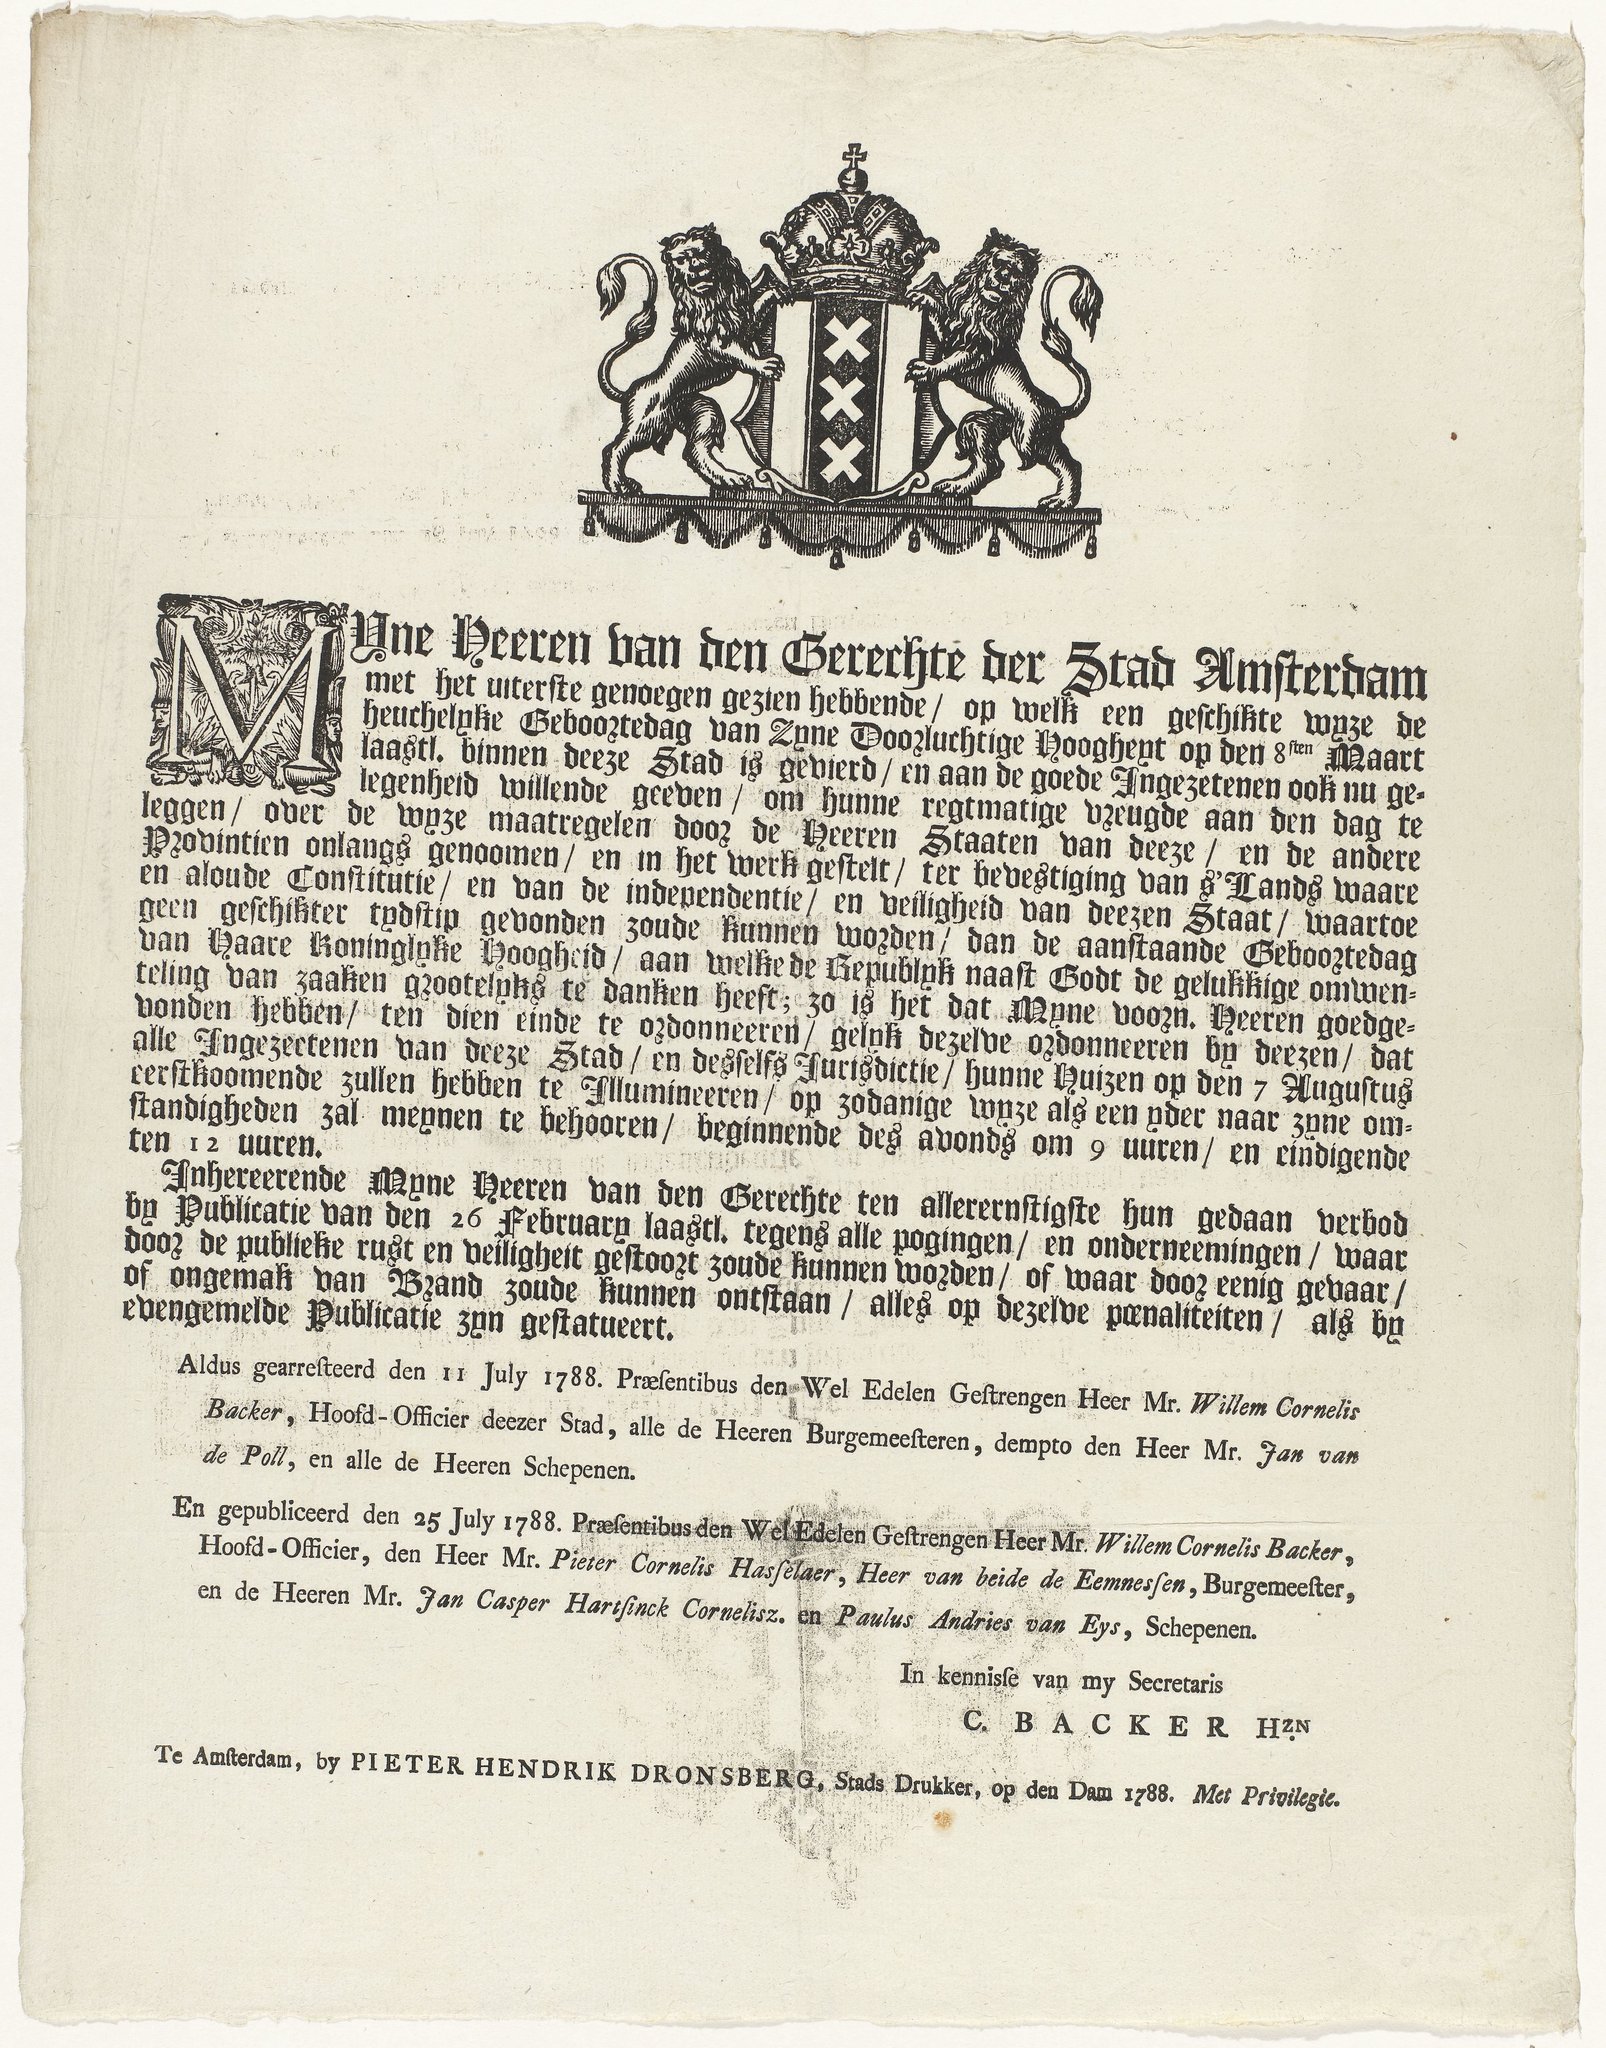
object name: text sheet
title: Storm op 't Y, den 3.en July, 1788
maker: pieter hendrik dronsberg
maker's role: printer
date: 1788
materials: paper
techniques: letterpress printing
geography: amsterdam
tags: berlin, painter, draughtsman, wilhelmina of prussia (princess of orange), amsterdam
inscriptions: collector's mark: Lugt 2228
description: Verordening van de stad Amsterdam om te illumineren op de verjaardag van de prinses van Oranje op 7 augustus 1788. Bovenaan een vignet met het stadswapen van Amsterdam.